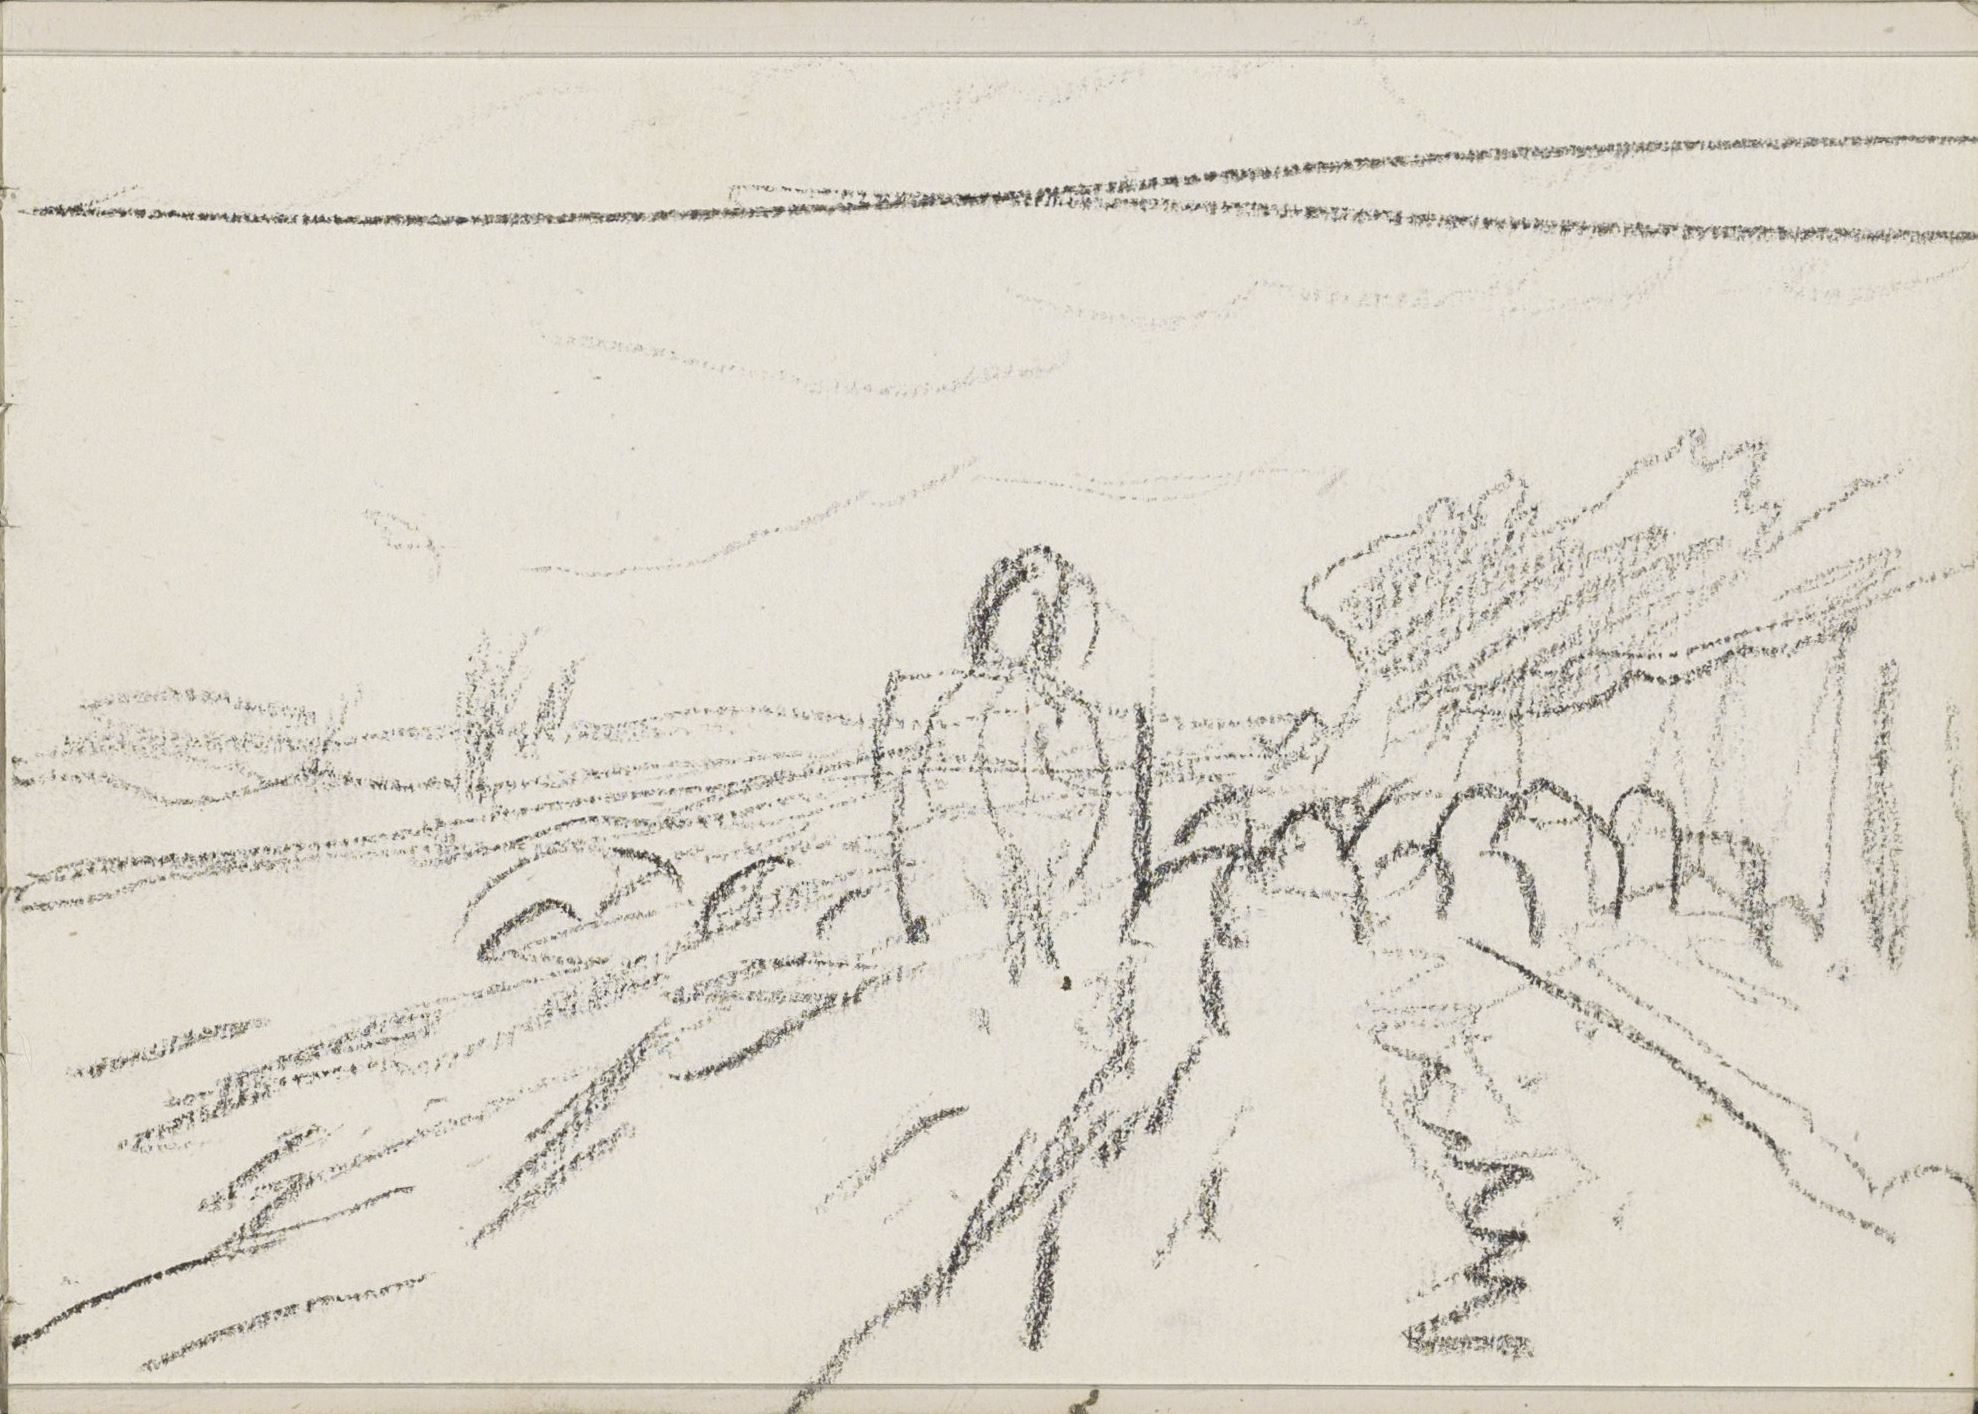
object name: sketchbook leaf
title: Herder met een schaapskudde in een landschap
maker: anton mauve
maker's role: draughtsman, painter, print maker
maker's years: 1838-1888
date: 1848-1888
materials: chalk, paper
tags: herding, herdsman, herdswoman, shepherd, shepherdess, cowherd, etc., sheep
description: Blad 10 recto uit een schetsboek met 31 bladen.